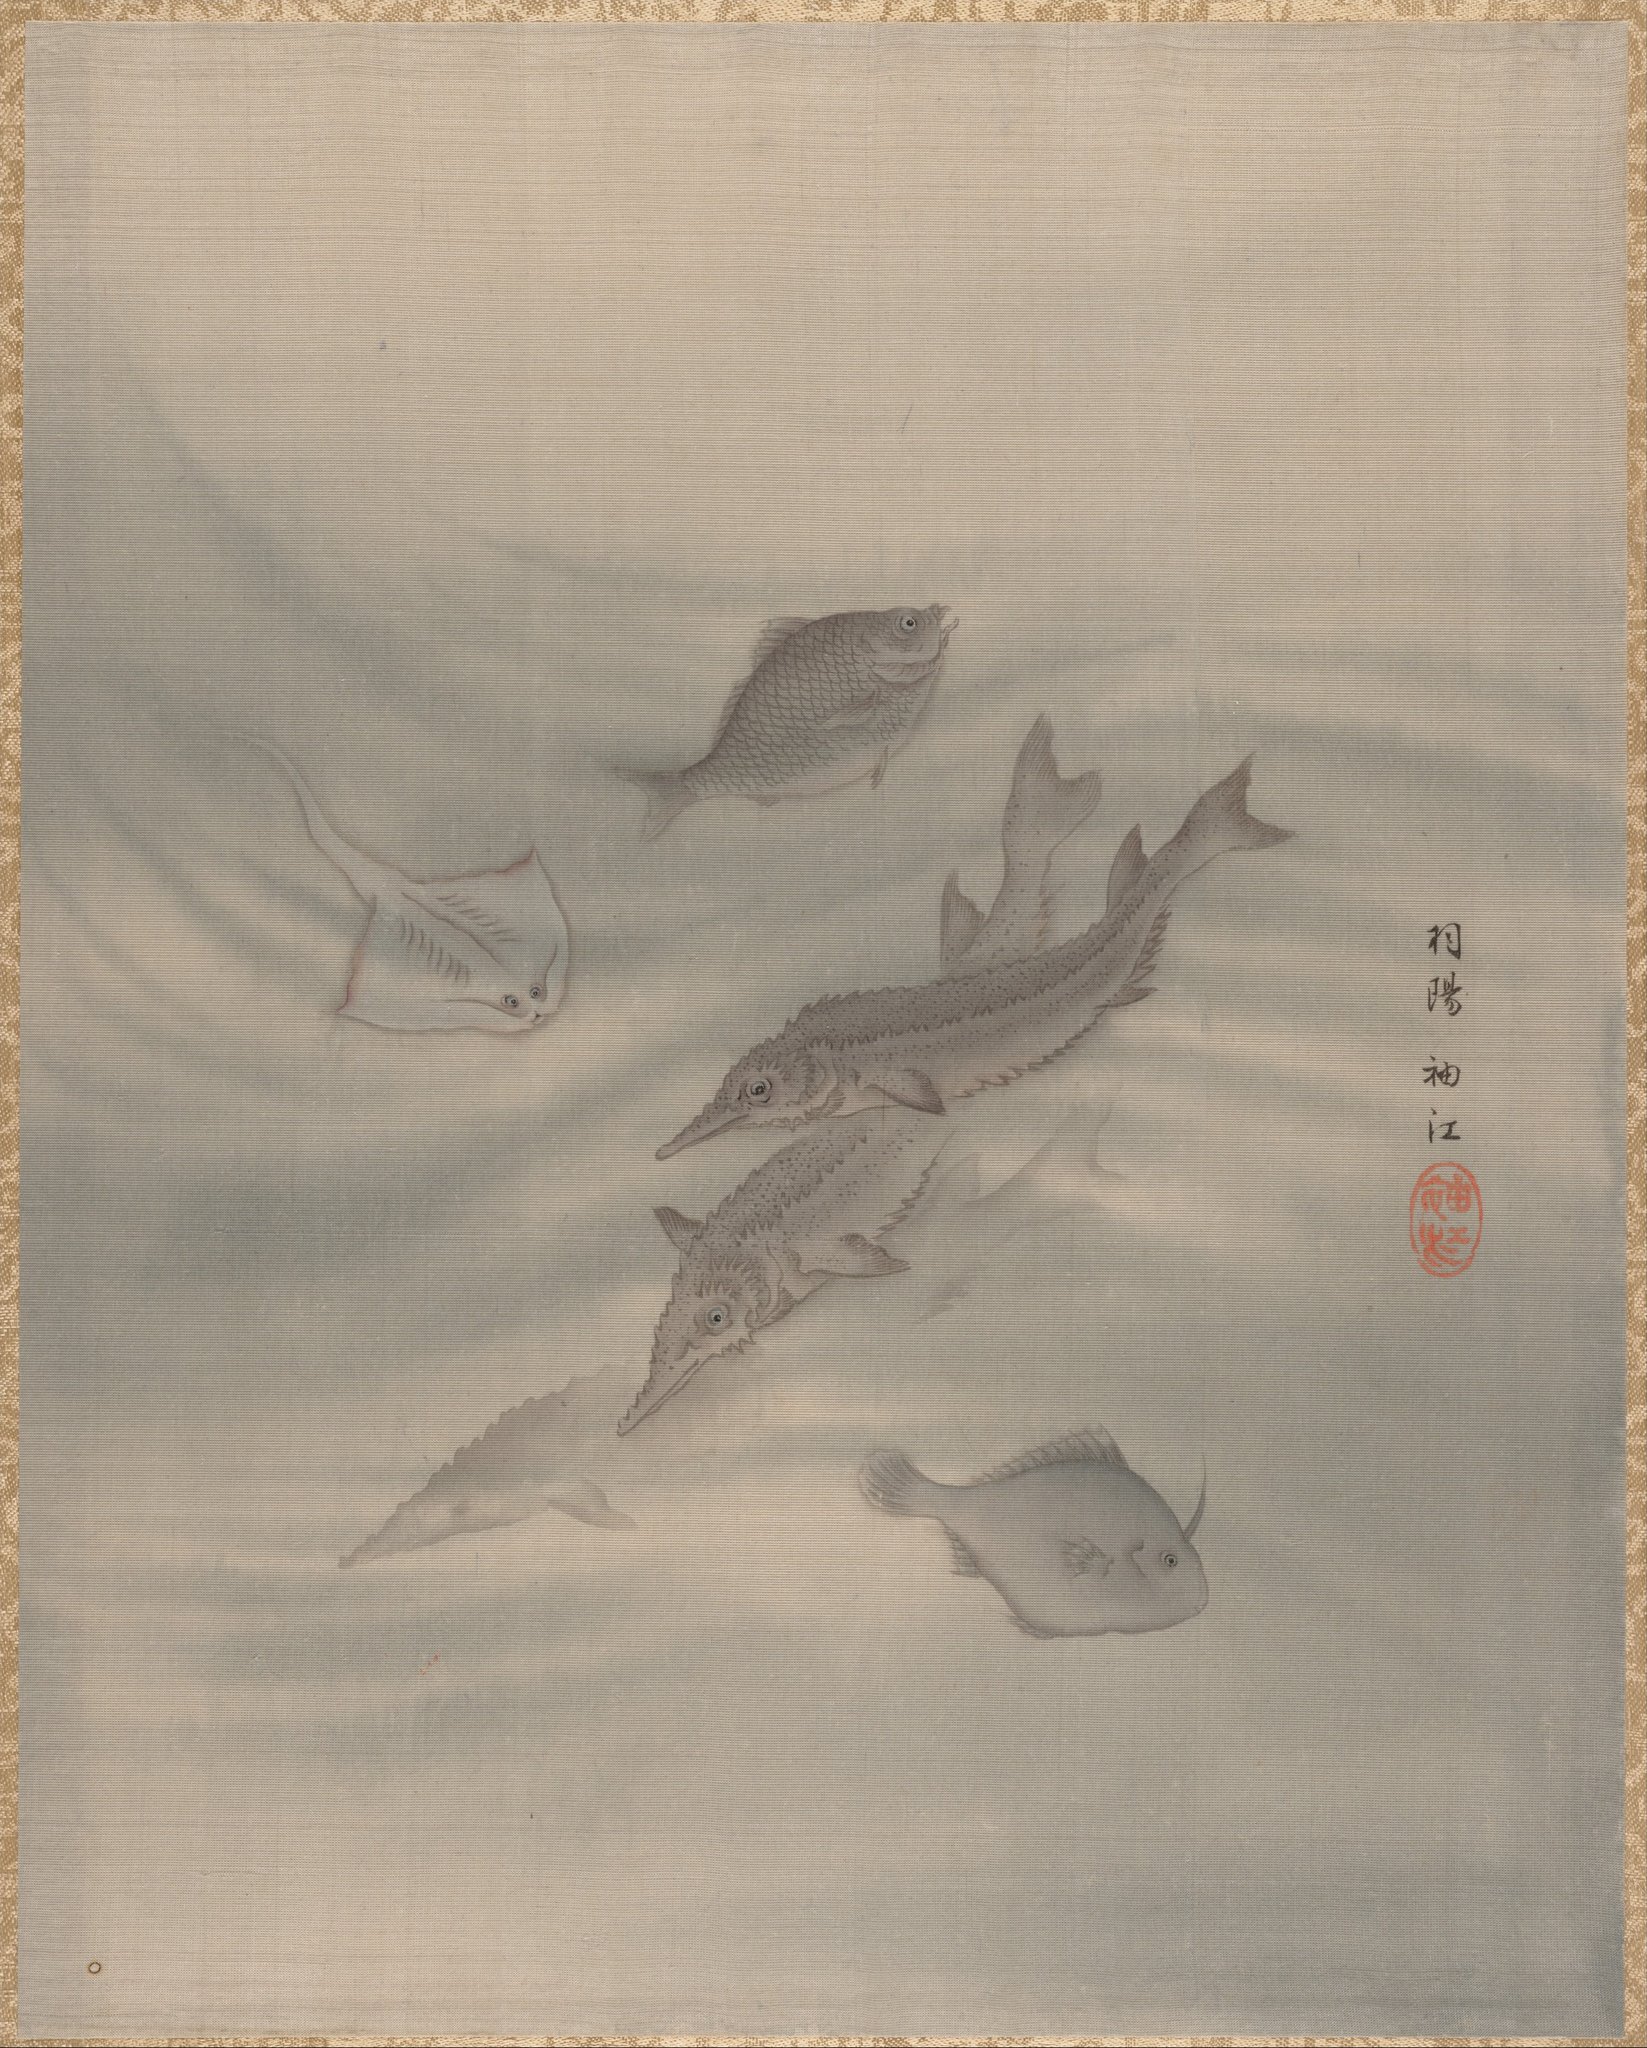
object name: album leaf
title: Fishes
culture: japanese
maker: seki shūkō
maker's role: artist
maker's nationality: japanese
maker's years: 1858-1915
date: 1890-1892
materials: silk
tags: fish